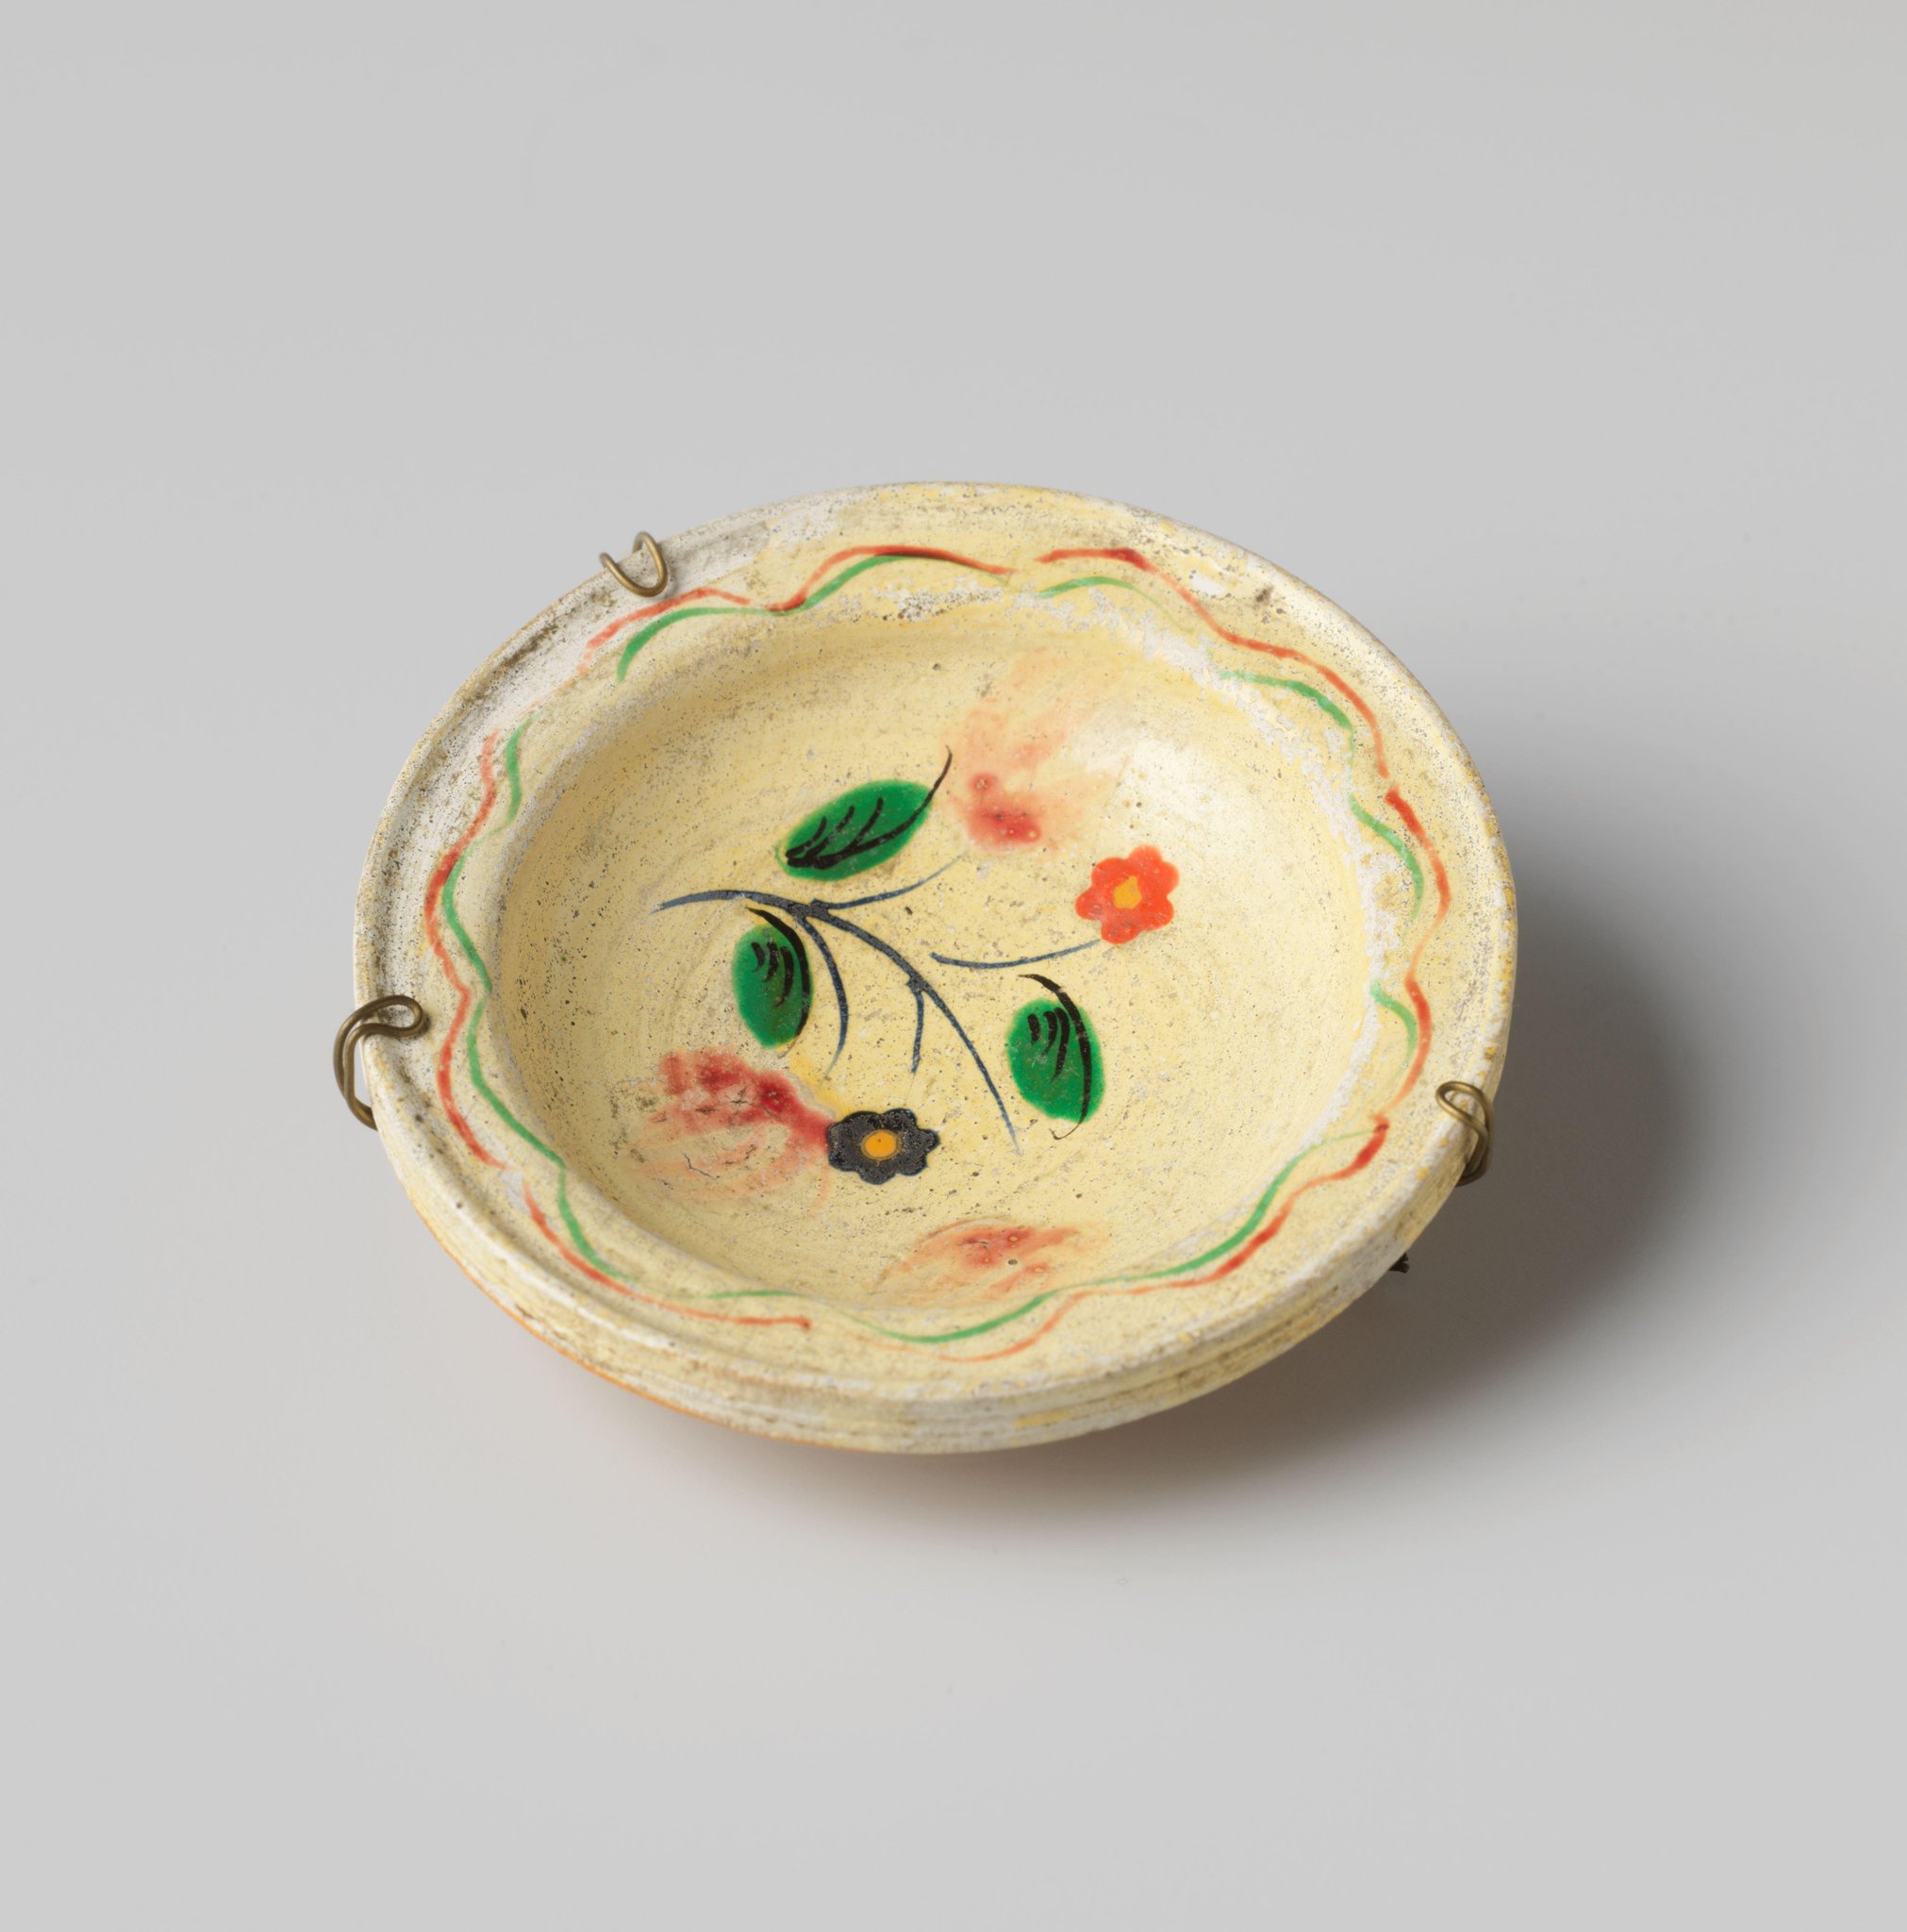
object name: platter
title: Schotel, de bovenzijde beschilderd met rode golfrand en bloemmotief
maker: Anonymous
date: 1700-1799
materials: wood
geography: amsterdam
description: Een ronde houten schotel, onderkant lichtbruin geschilderd, bovenkant lichtgeel met groen en rode golfrand en bloemmotief in de kleurstelling groen, rood, zwart, geel en roze. Imitatie van Duits, Hessisch aardewerk. Montuur van koperdraad.